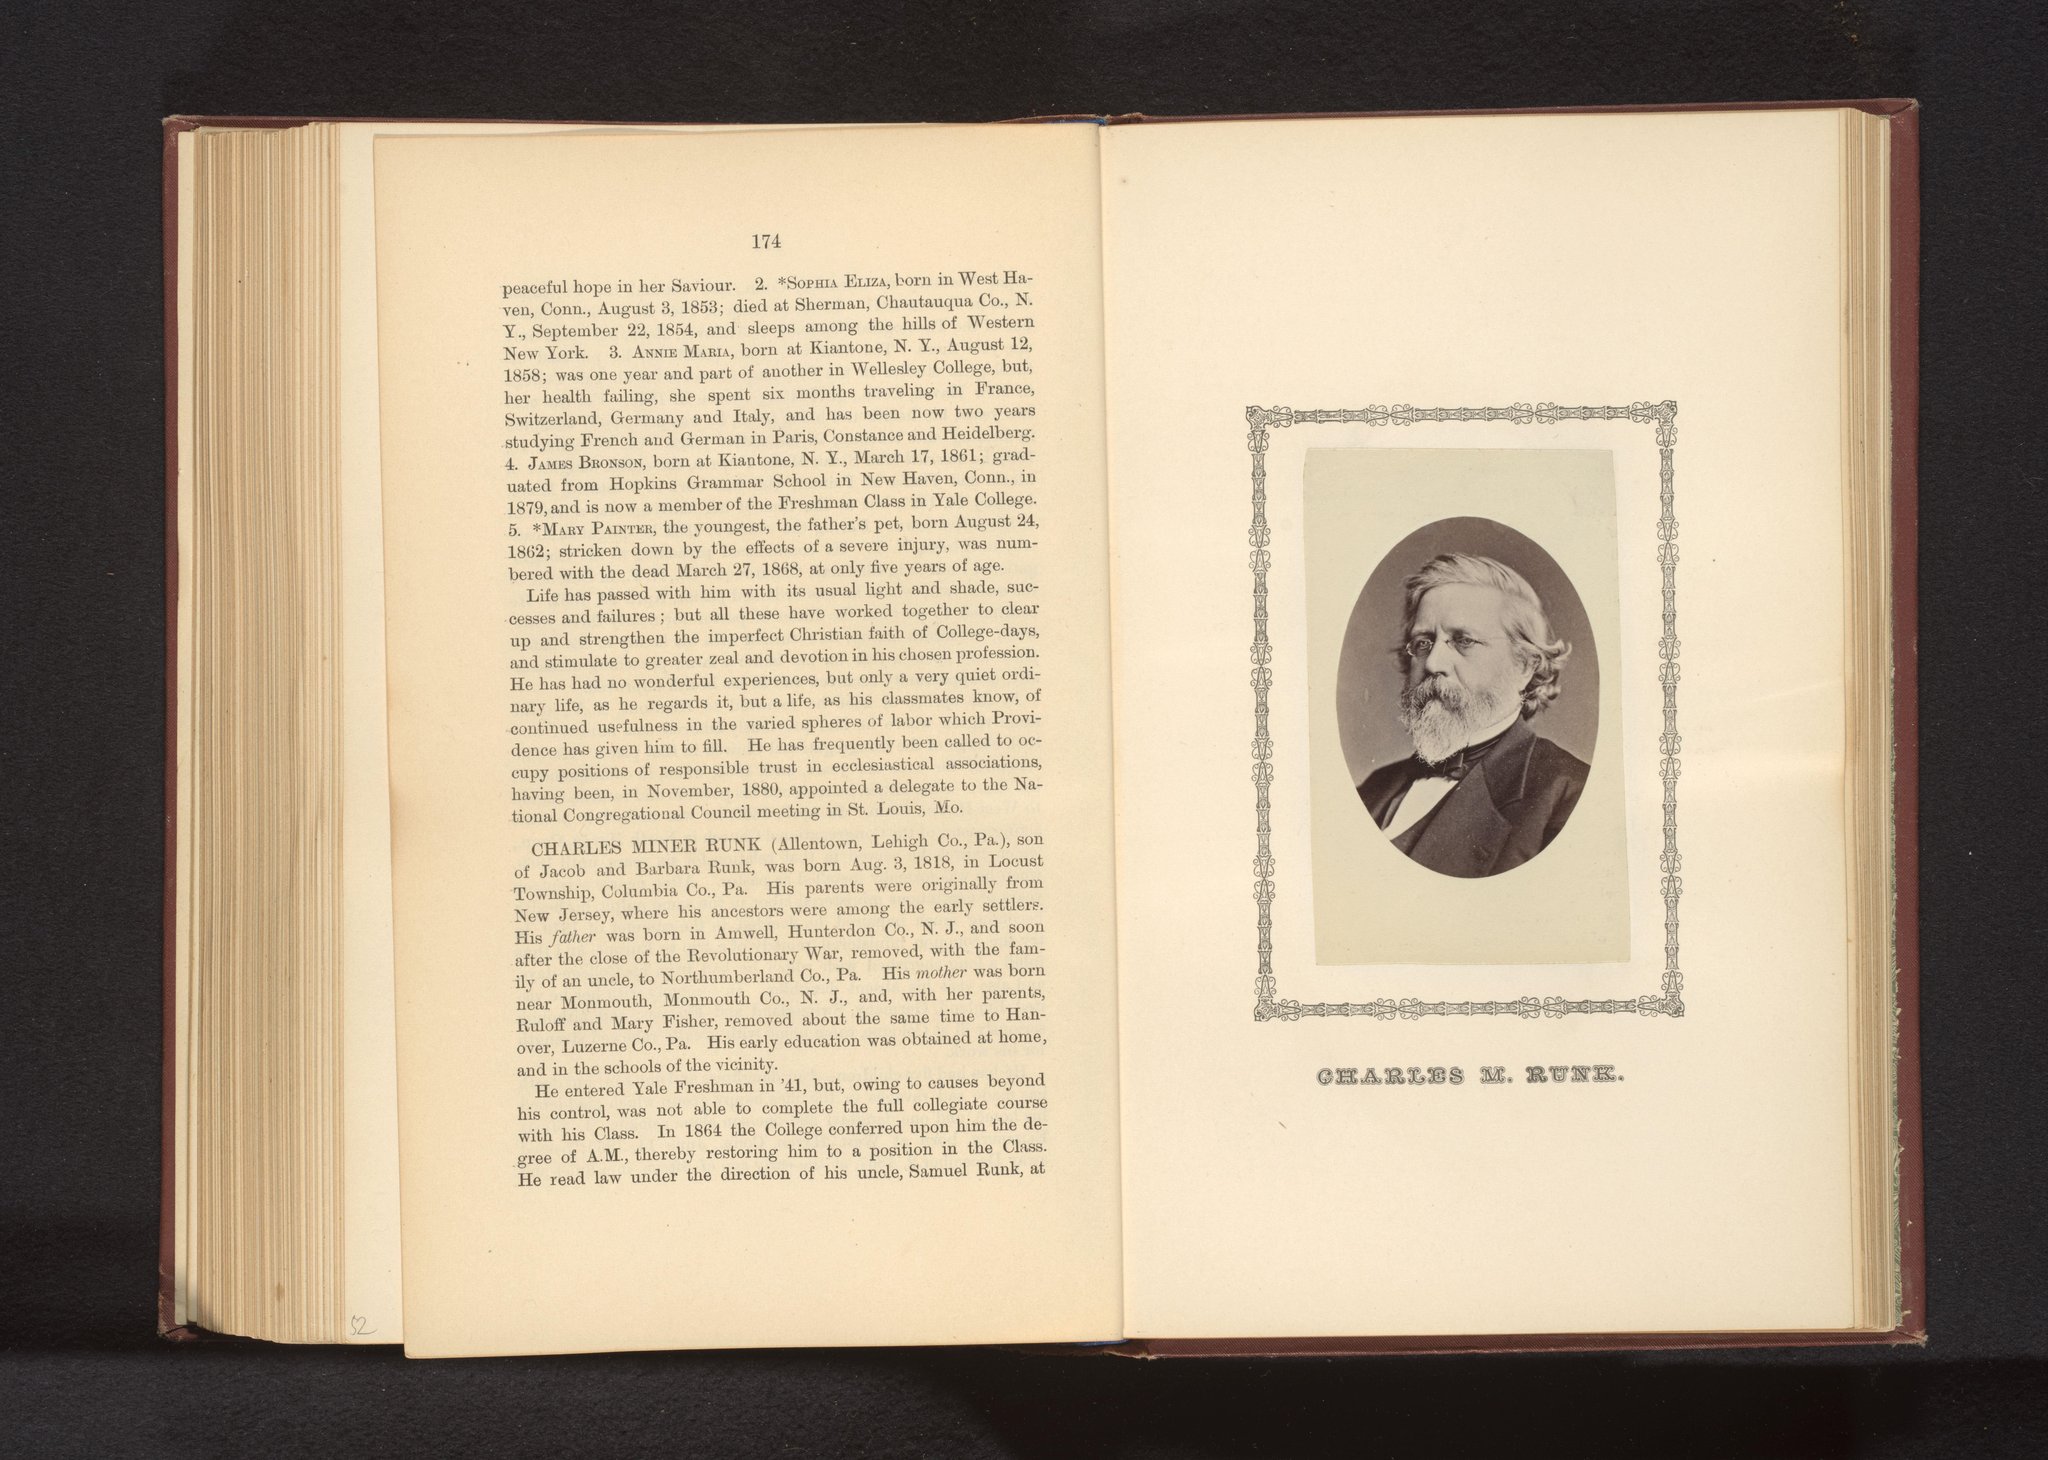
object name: page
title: Charles M. Runk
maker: Anonymous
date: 1876-1881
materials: photographic support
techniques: albumen print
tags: adult man